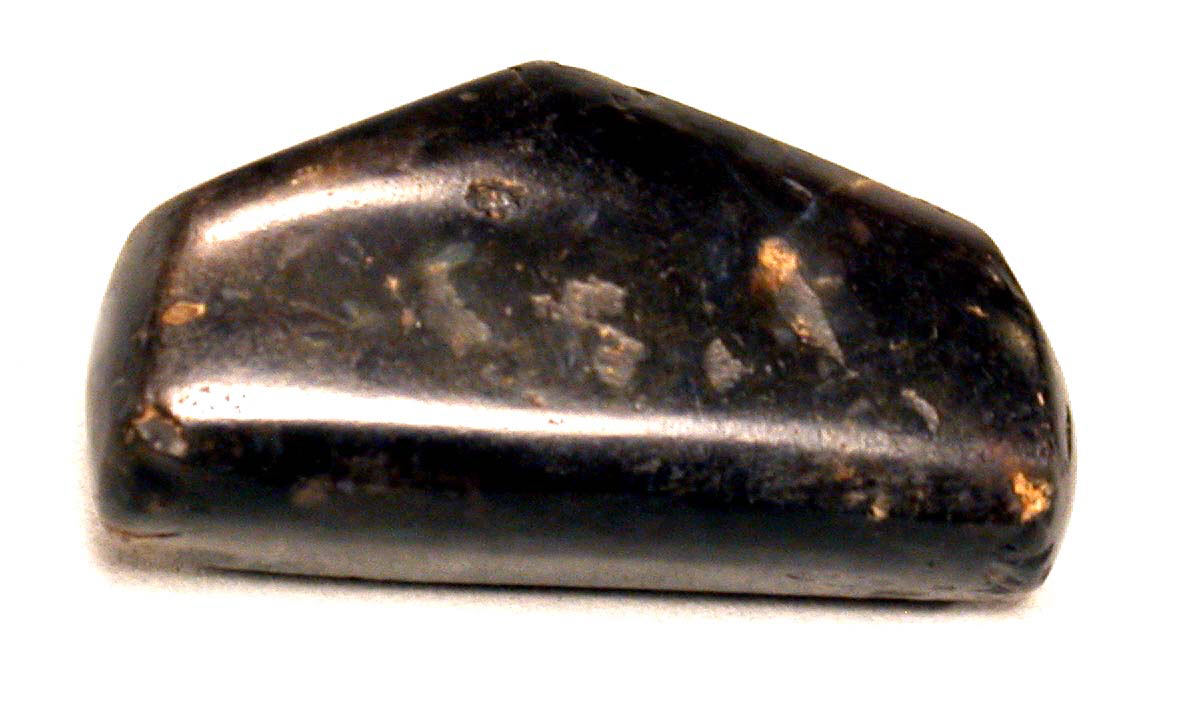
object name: ritual stone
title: Stone Pulidor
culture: mexican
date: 1501-1600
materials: stone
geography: mexico